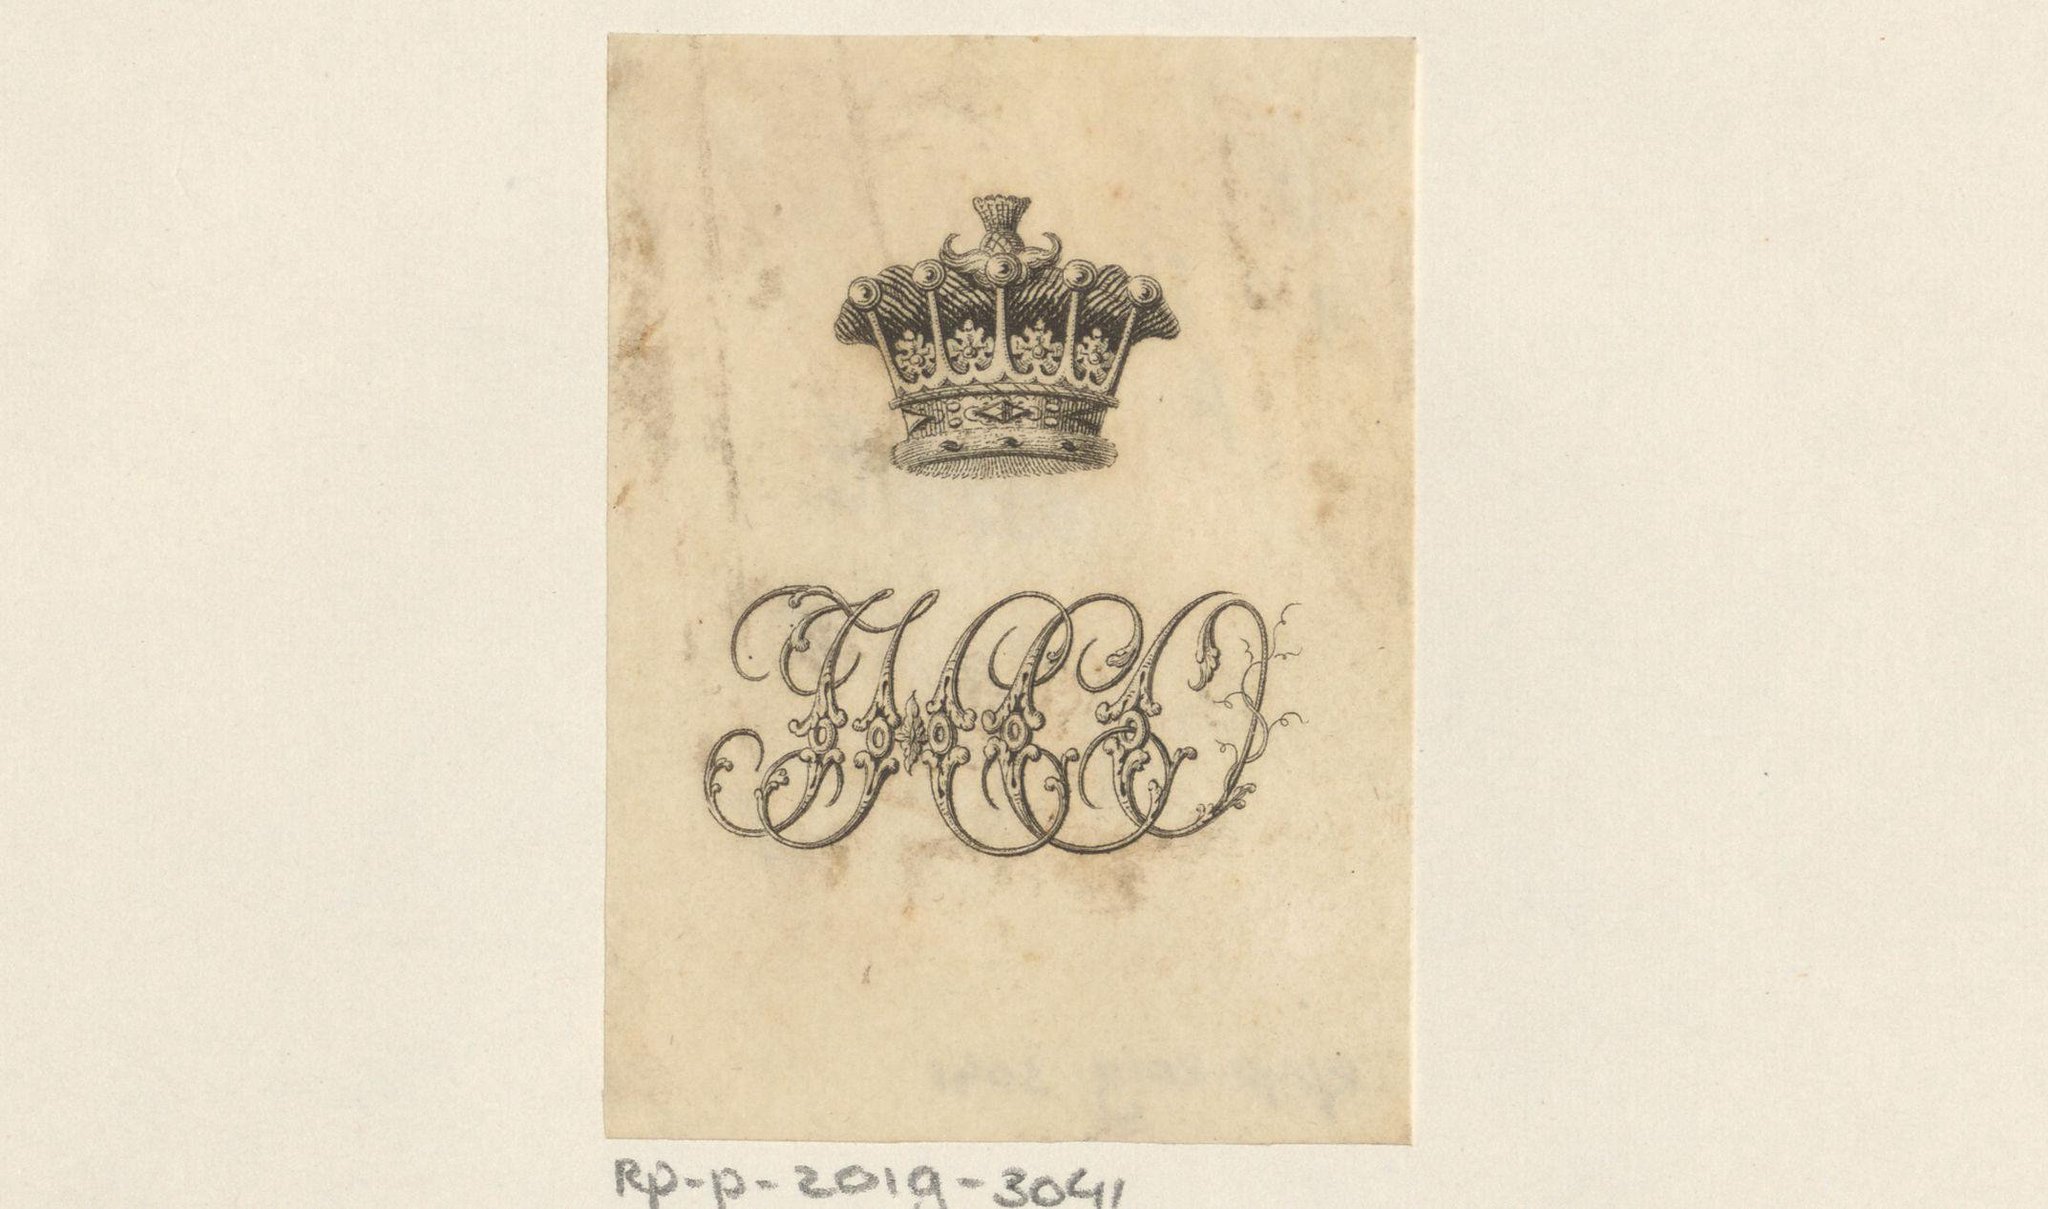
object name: bookplate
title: Ex libris van onbekend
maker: Anonymous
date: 1750-1849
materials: paper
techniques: engraving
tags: crown (symbol of sovereignty), initial